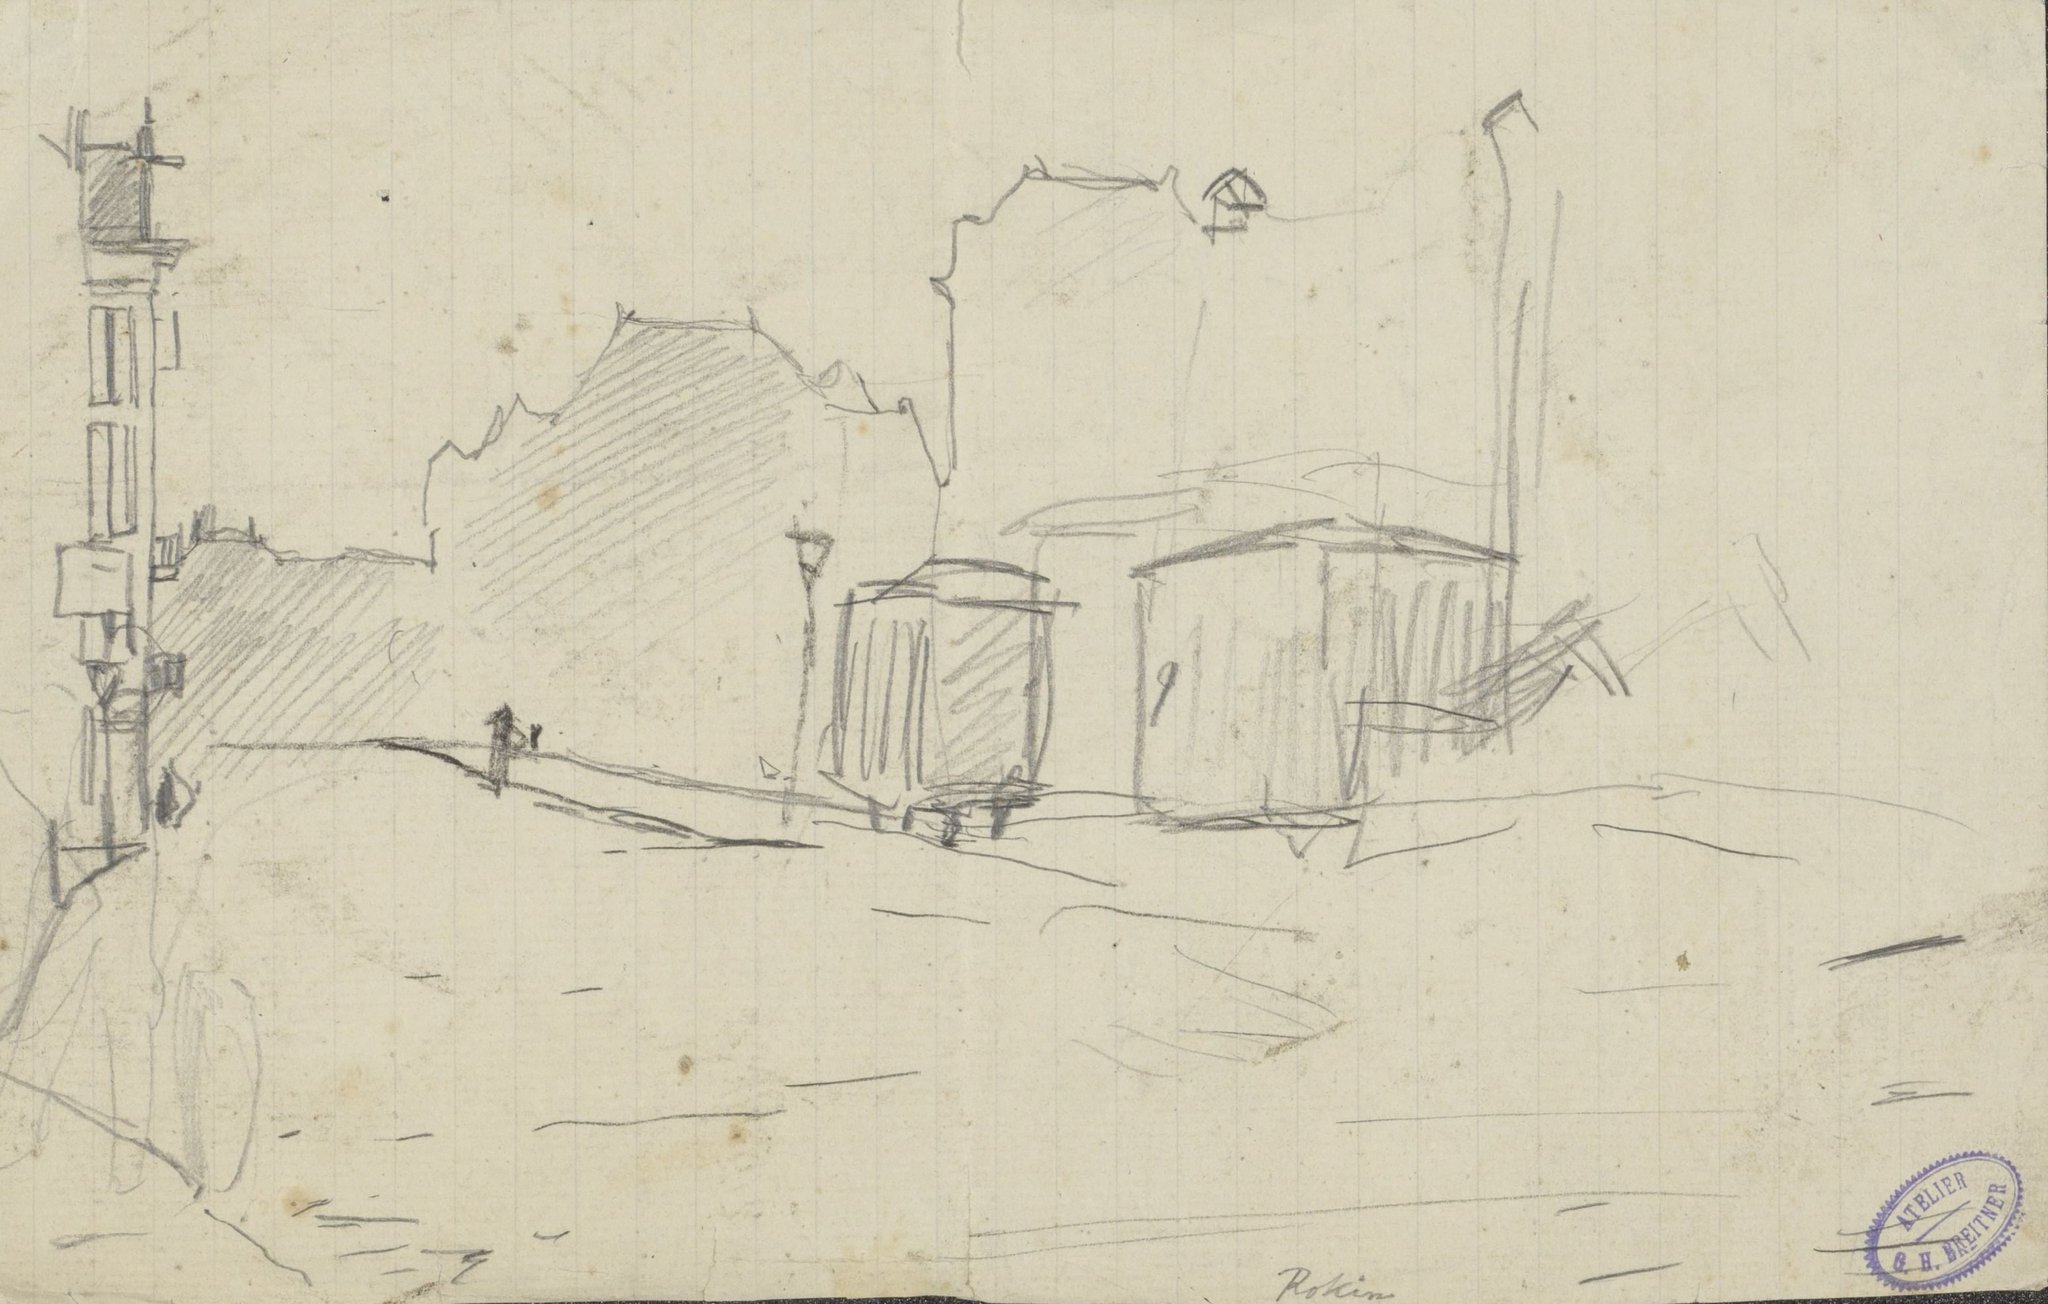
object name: drawing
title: Rokin te Amsterdam, gezien vanuit kunstenaarsvereniging Arti et Amicitiae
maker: george hendrik breitner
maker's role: draughtsman, painter, print maker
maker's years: 1857-1923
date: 1898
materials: chalk, paper, pencil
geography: amsterdam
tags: urban housing, street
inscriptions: annotation: ‘Rokin’, workshop stamp: Lugt 291d